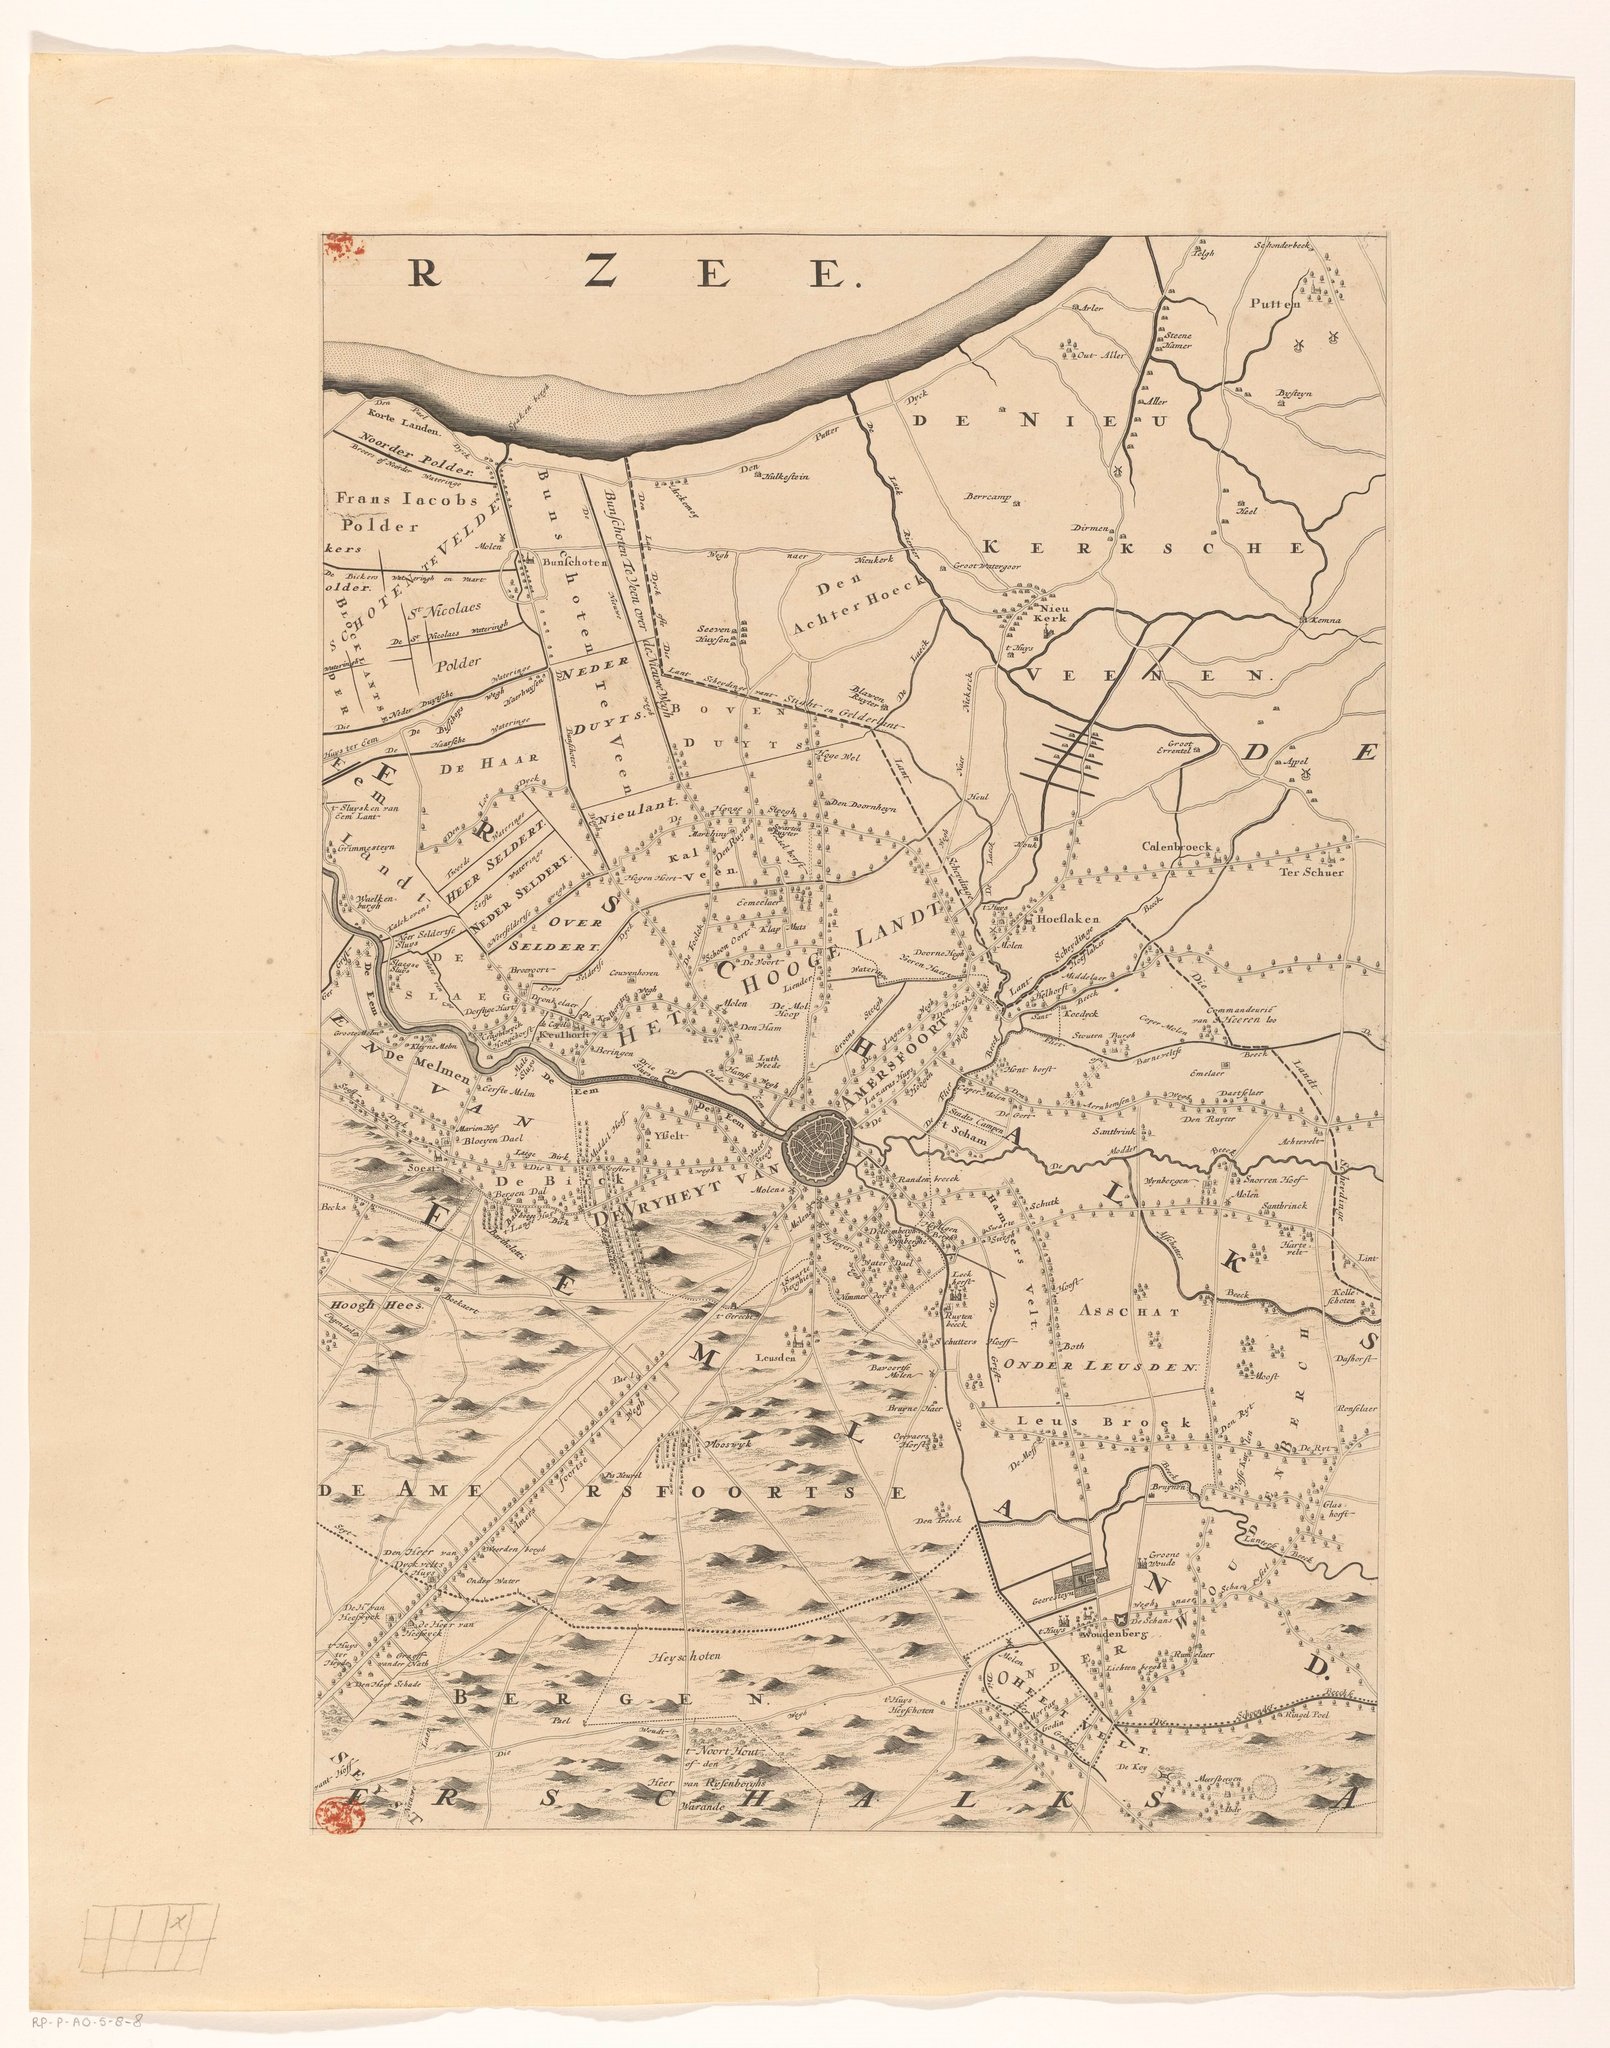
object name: print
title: Kaart van de provincie Utrecht (vierde deel van boven)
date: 1696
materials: paper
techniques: engraving, etching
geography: utrecht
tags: maps of separate countries or regions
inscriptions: collector's mark: Lugt 195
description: In de literatuur is altijd verondersteld dat er vier staten van deze kaart bestonden en dat de gewijzigde titel en inhoud van de titelcartouche, advertentie onder de cartouche, schaalstok links van de cartouche en andere wijzigingen op de kaart op de veronderstelde tweede staat in 1743 zouden zijn aangebracht door Covens & Mortier. Het huidige exemplaar is echter een tot dusver onbekende tussenstaat die niet alleen aantoont dat de genoemde veranderingen eerder zijn aangebracht, maar ook dat deze tweede staat is uitgegeven door Nicolaes Visscher II, de uitgever van de eerste staat.